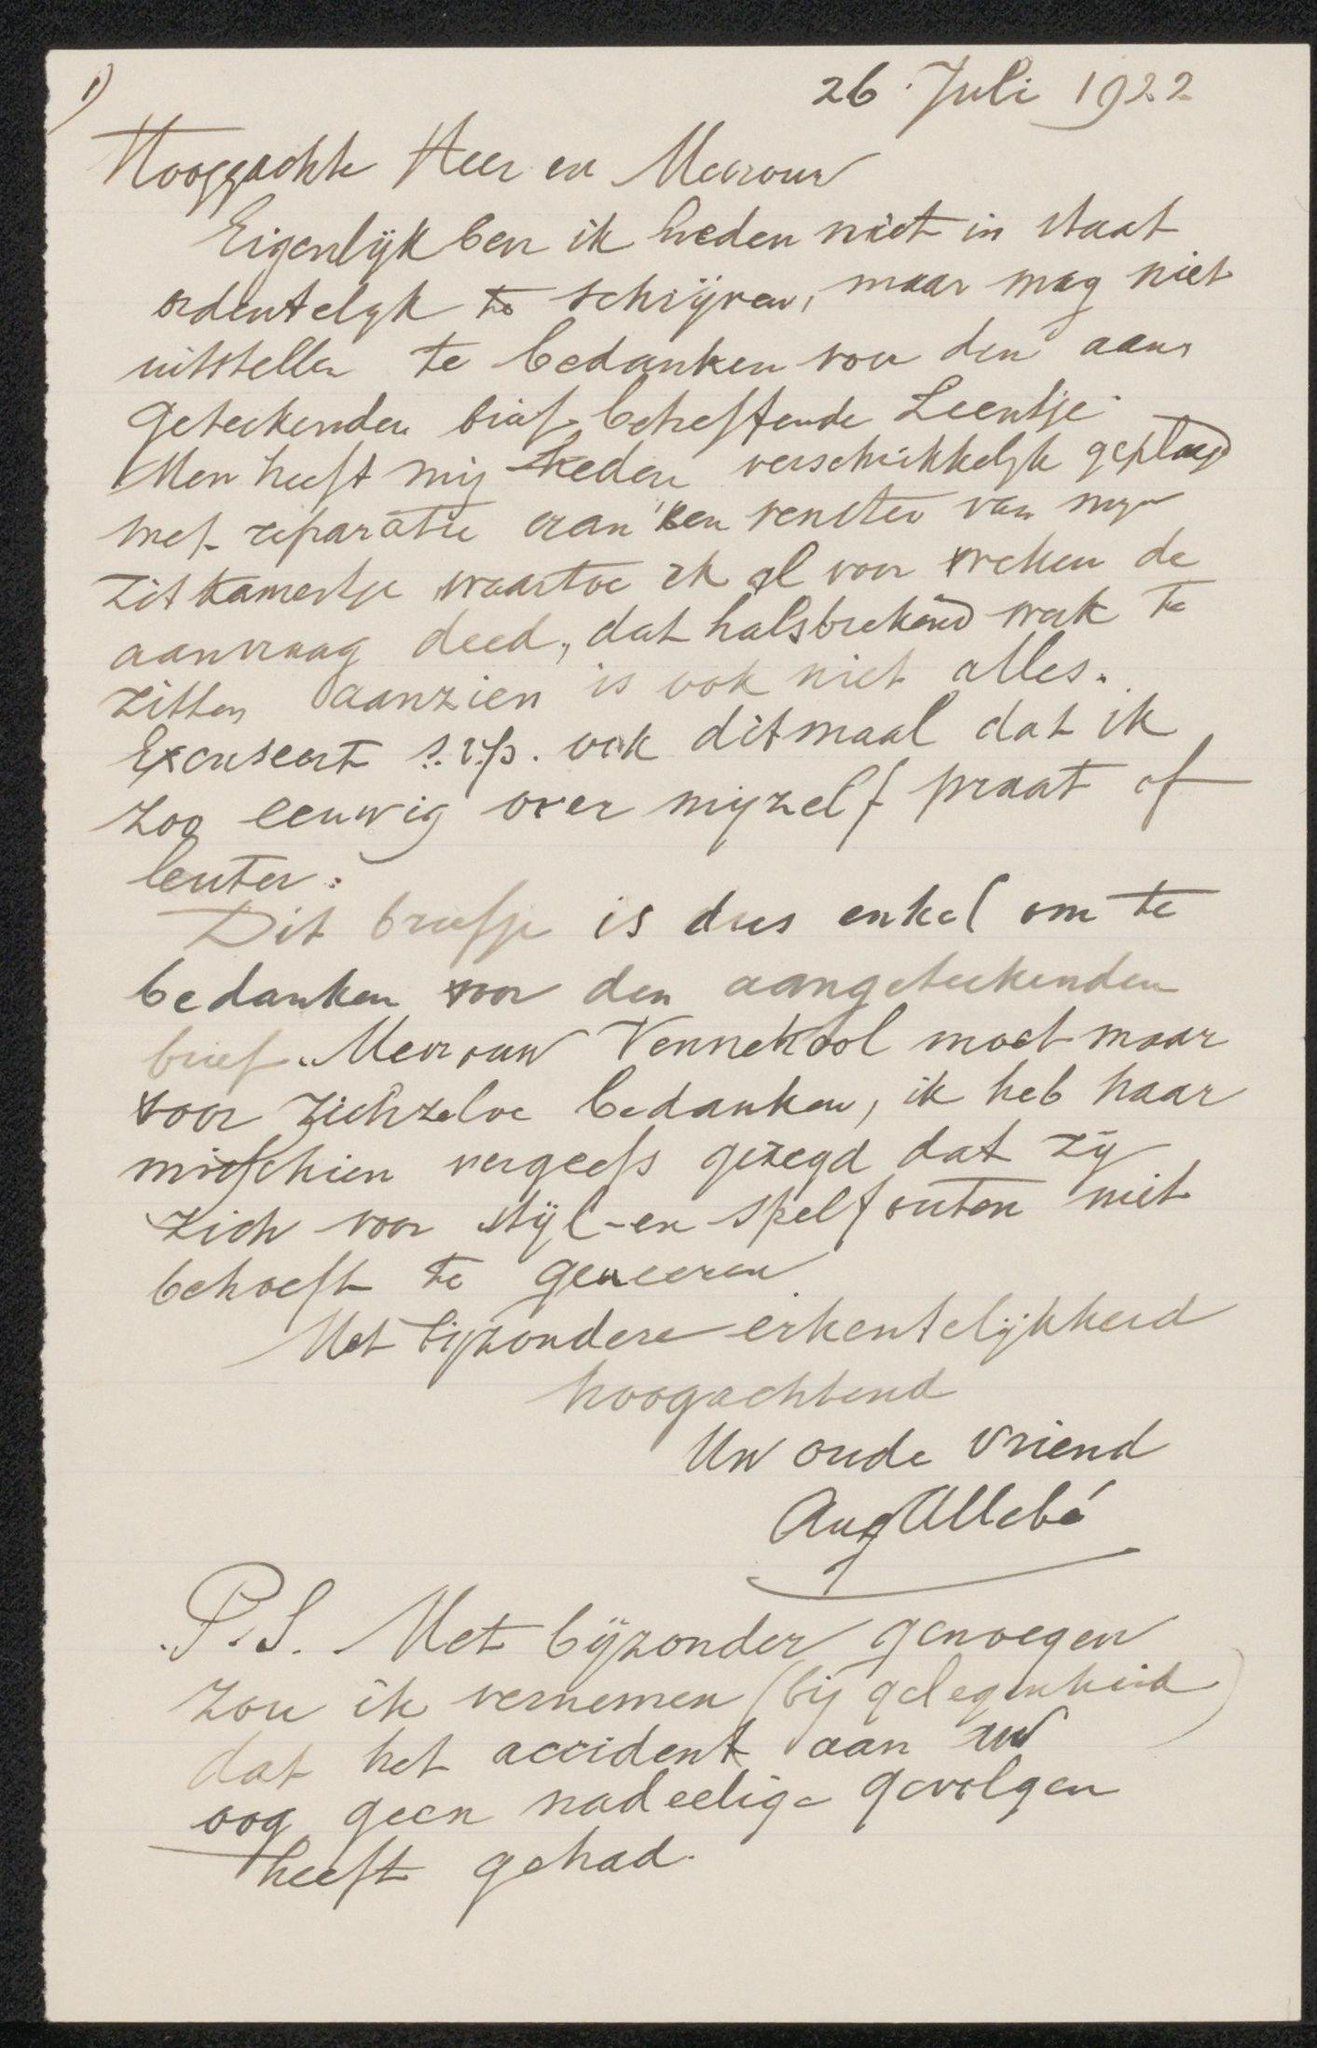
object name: letter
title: Brief aan August Max Wilhelm Carl Weber en Anne Antoinette Weber-Van Bosse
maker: august allebé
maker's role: draughtsman, print maker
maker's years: 1838-1927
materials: ink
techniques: pen, writing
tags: anne antoinette weber-van bosse, diseases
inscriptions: watermark